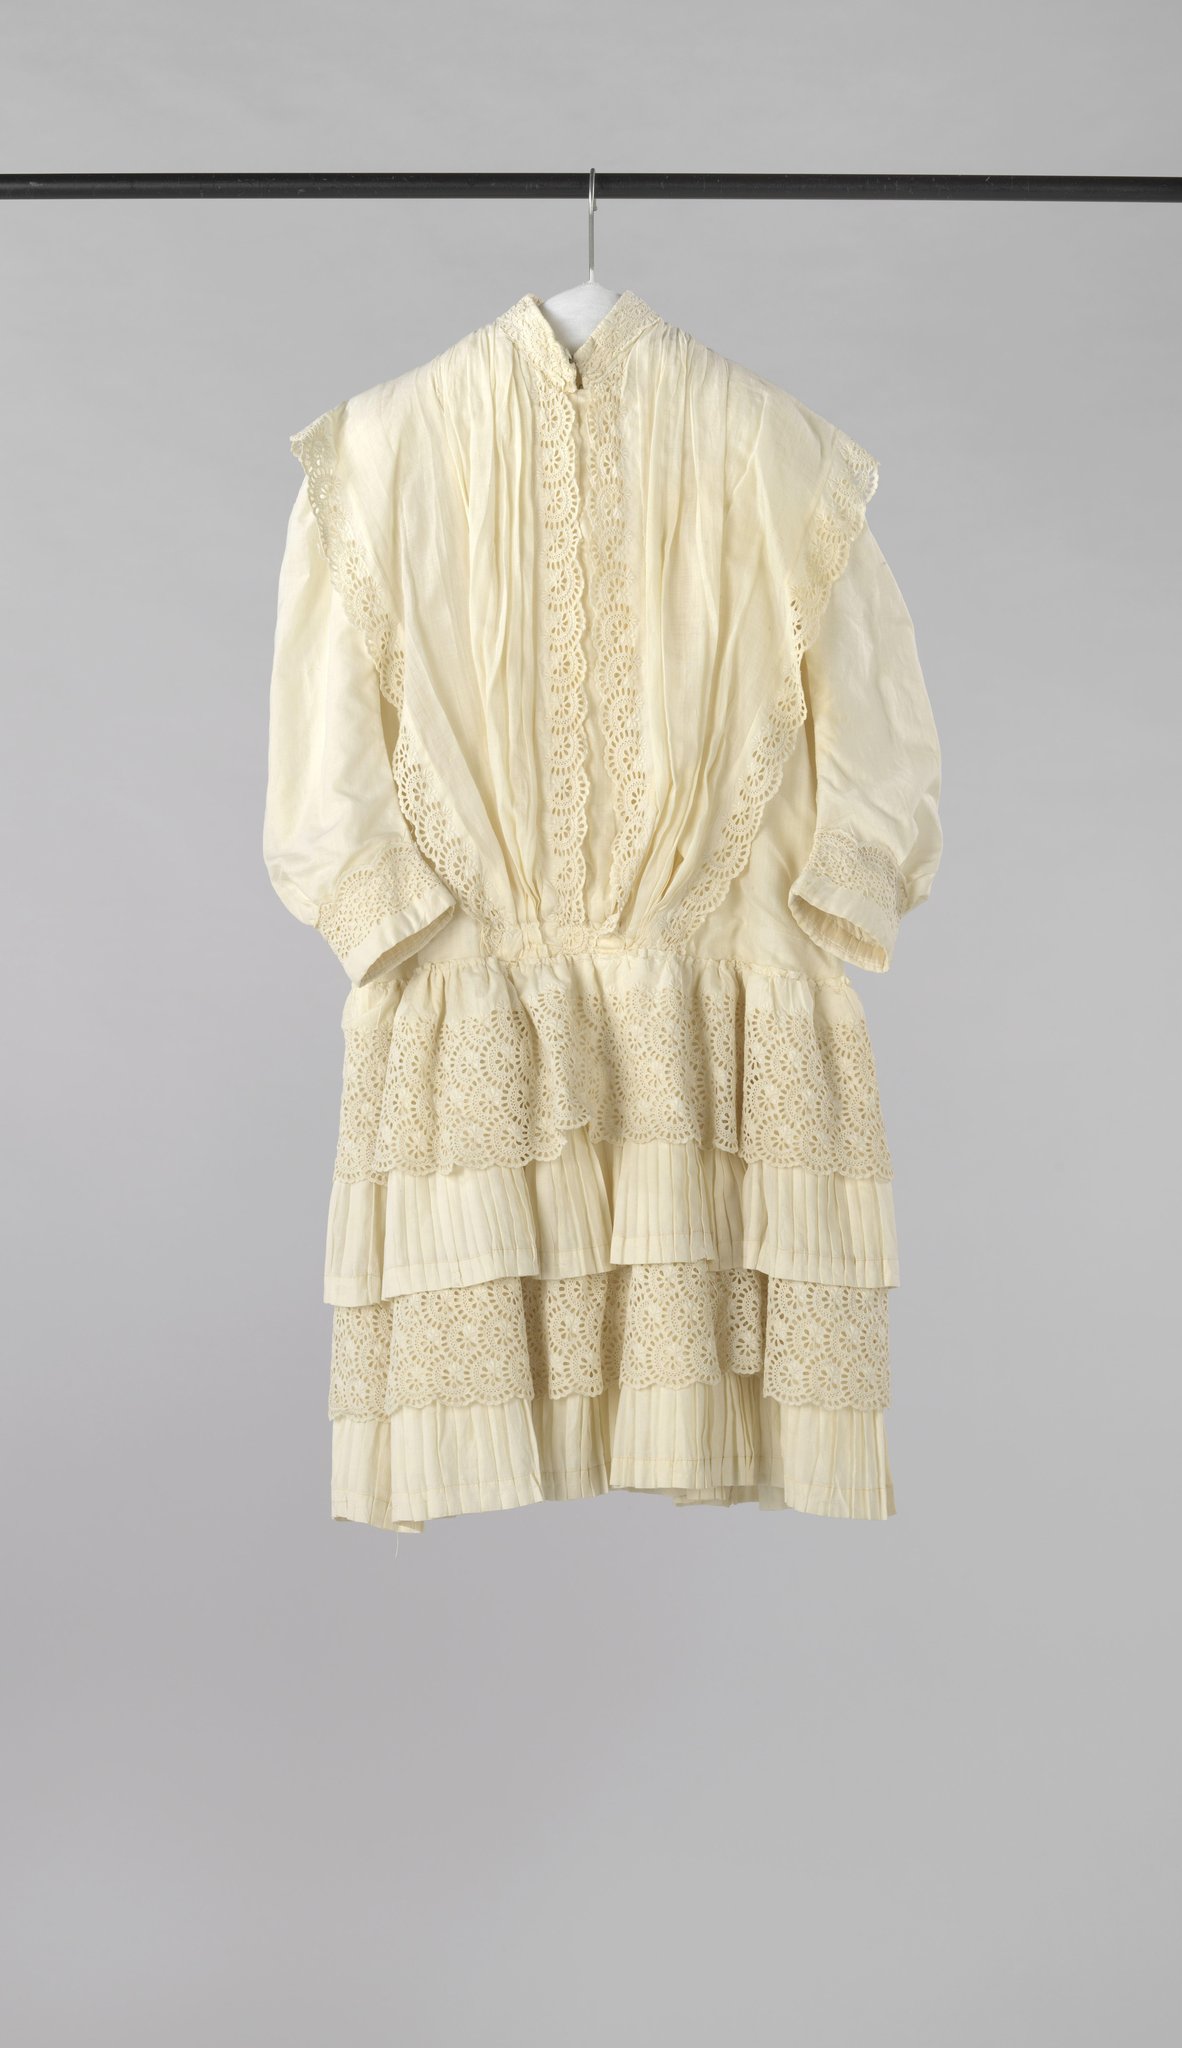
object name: main garment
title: Meisjesjurk met onderlaag van wit katoen met ingeweven verticale strepen en bovenlaag van wit katoen, versierd met plooien, ruches met plooien en randen Engels borduurwerk.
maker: Anonymous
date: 1890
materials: cotton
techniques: embroidered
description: Een meisjesjurk van creme mul met lange mouwen en hoge hals.